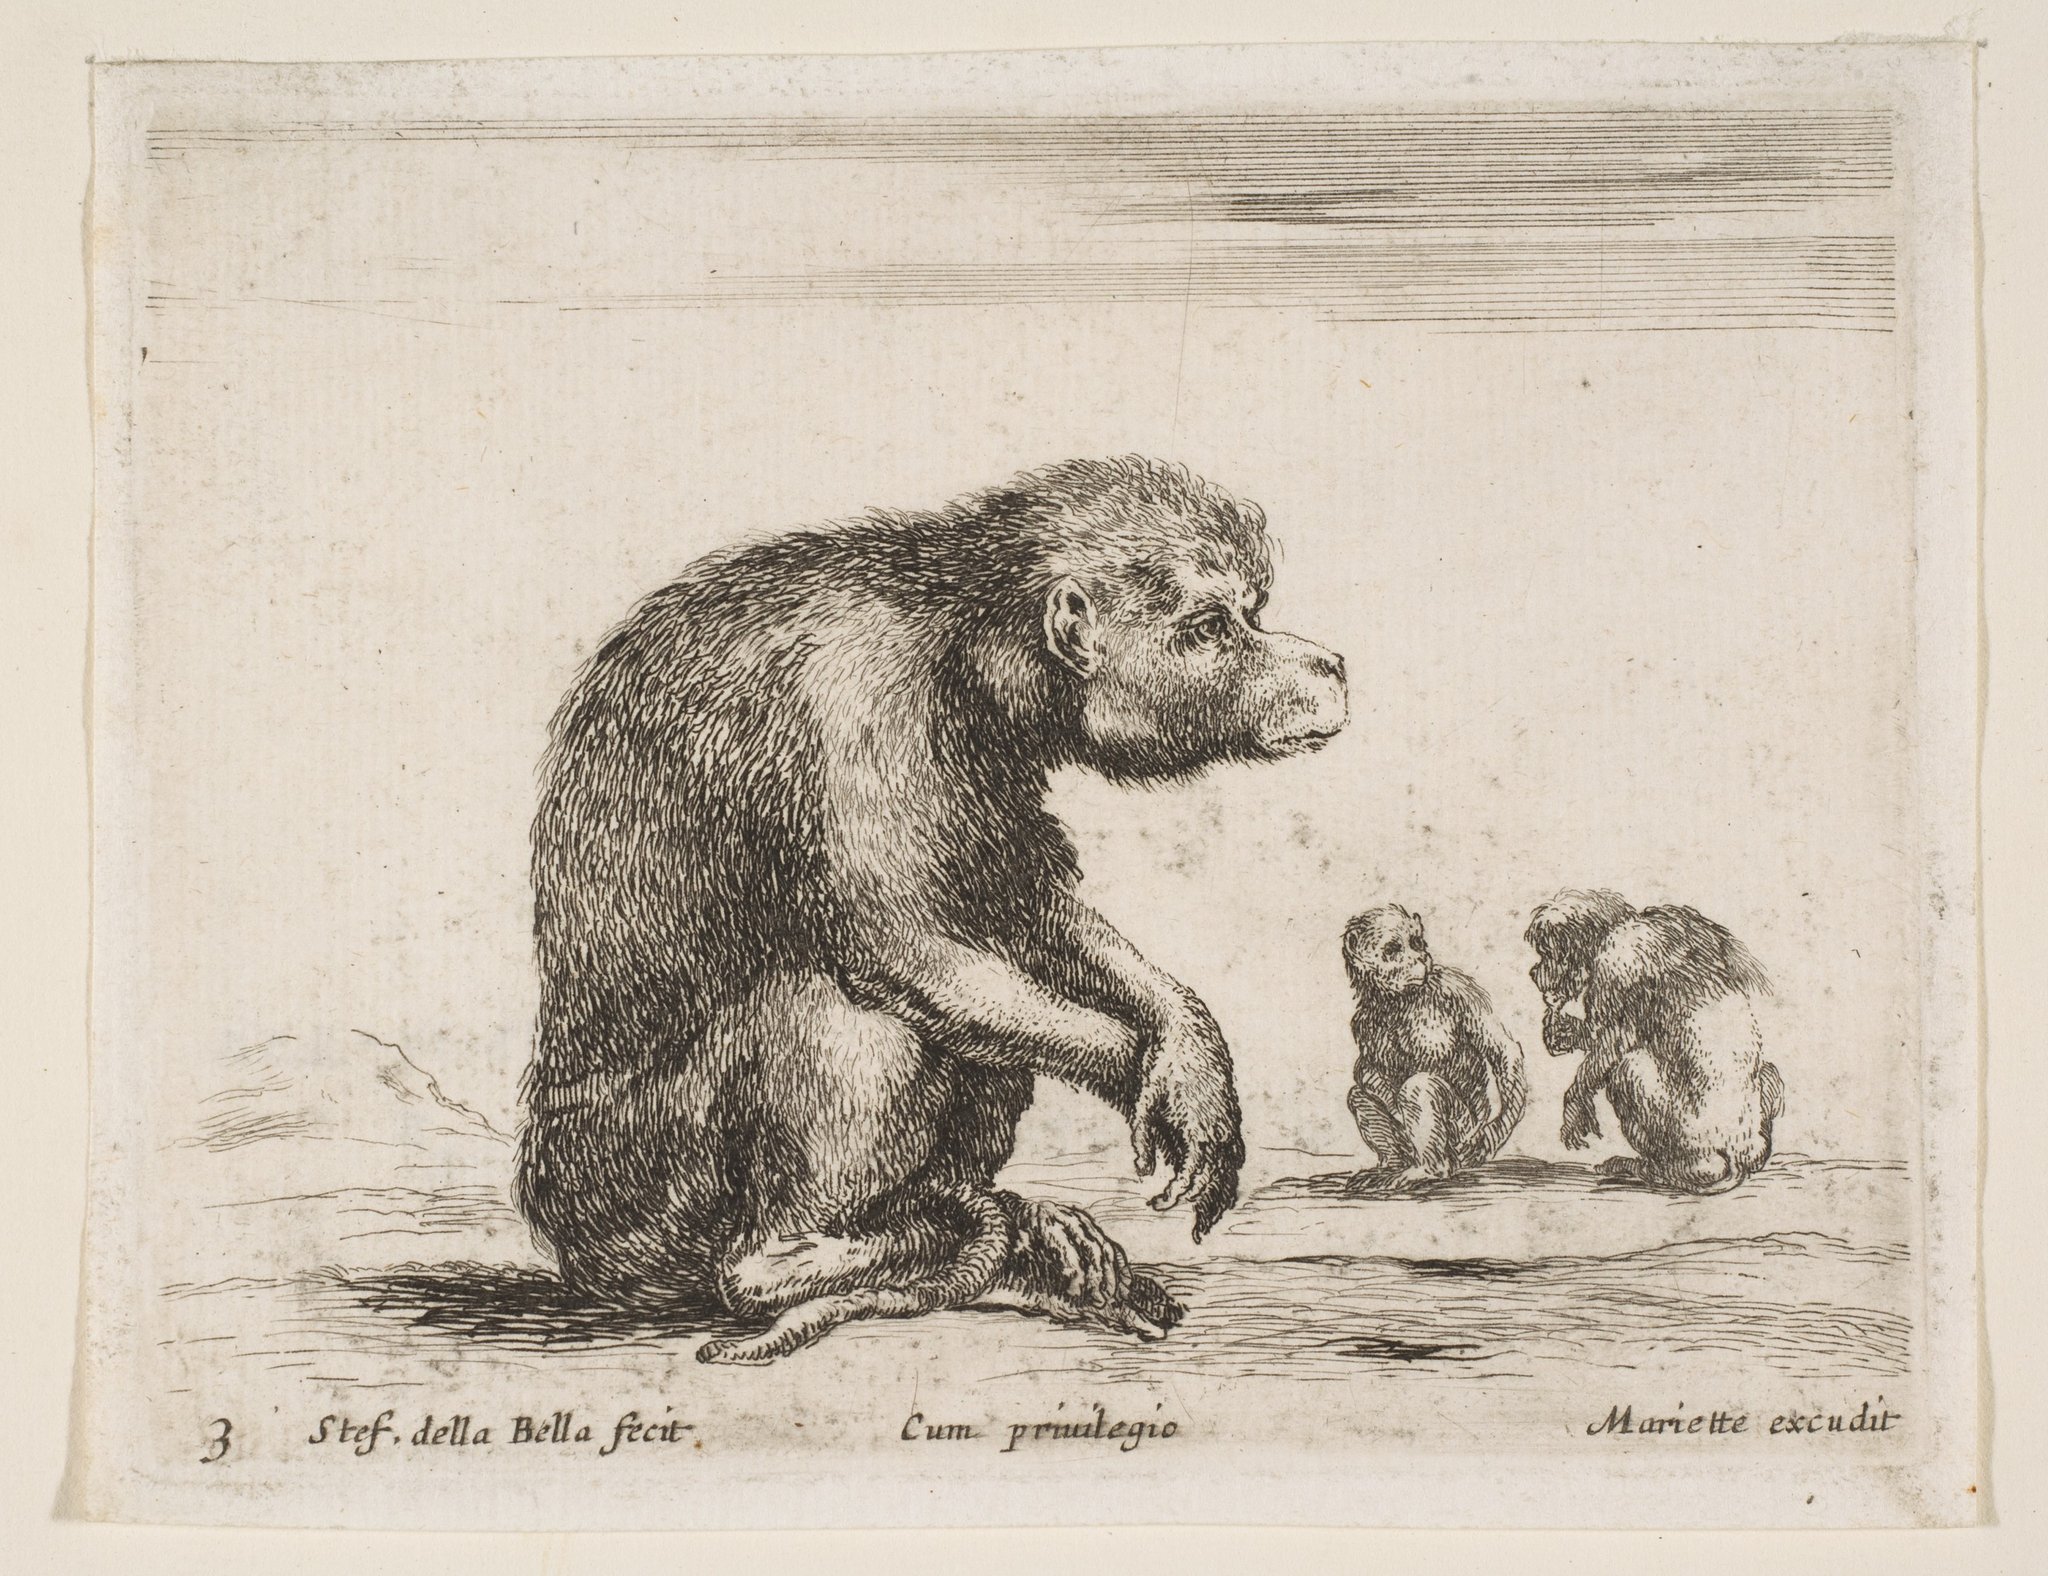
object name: print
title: Seated monkey, plate 3 from "Various Animals" (Diversi Animali)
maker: stefano della bella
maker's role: artist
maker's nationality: italian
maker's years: 1610-1664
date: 1641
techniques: etching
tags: monkeys